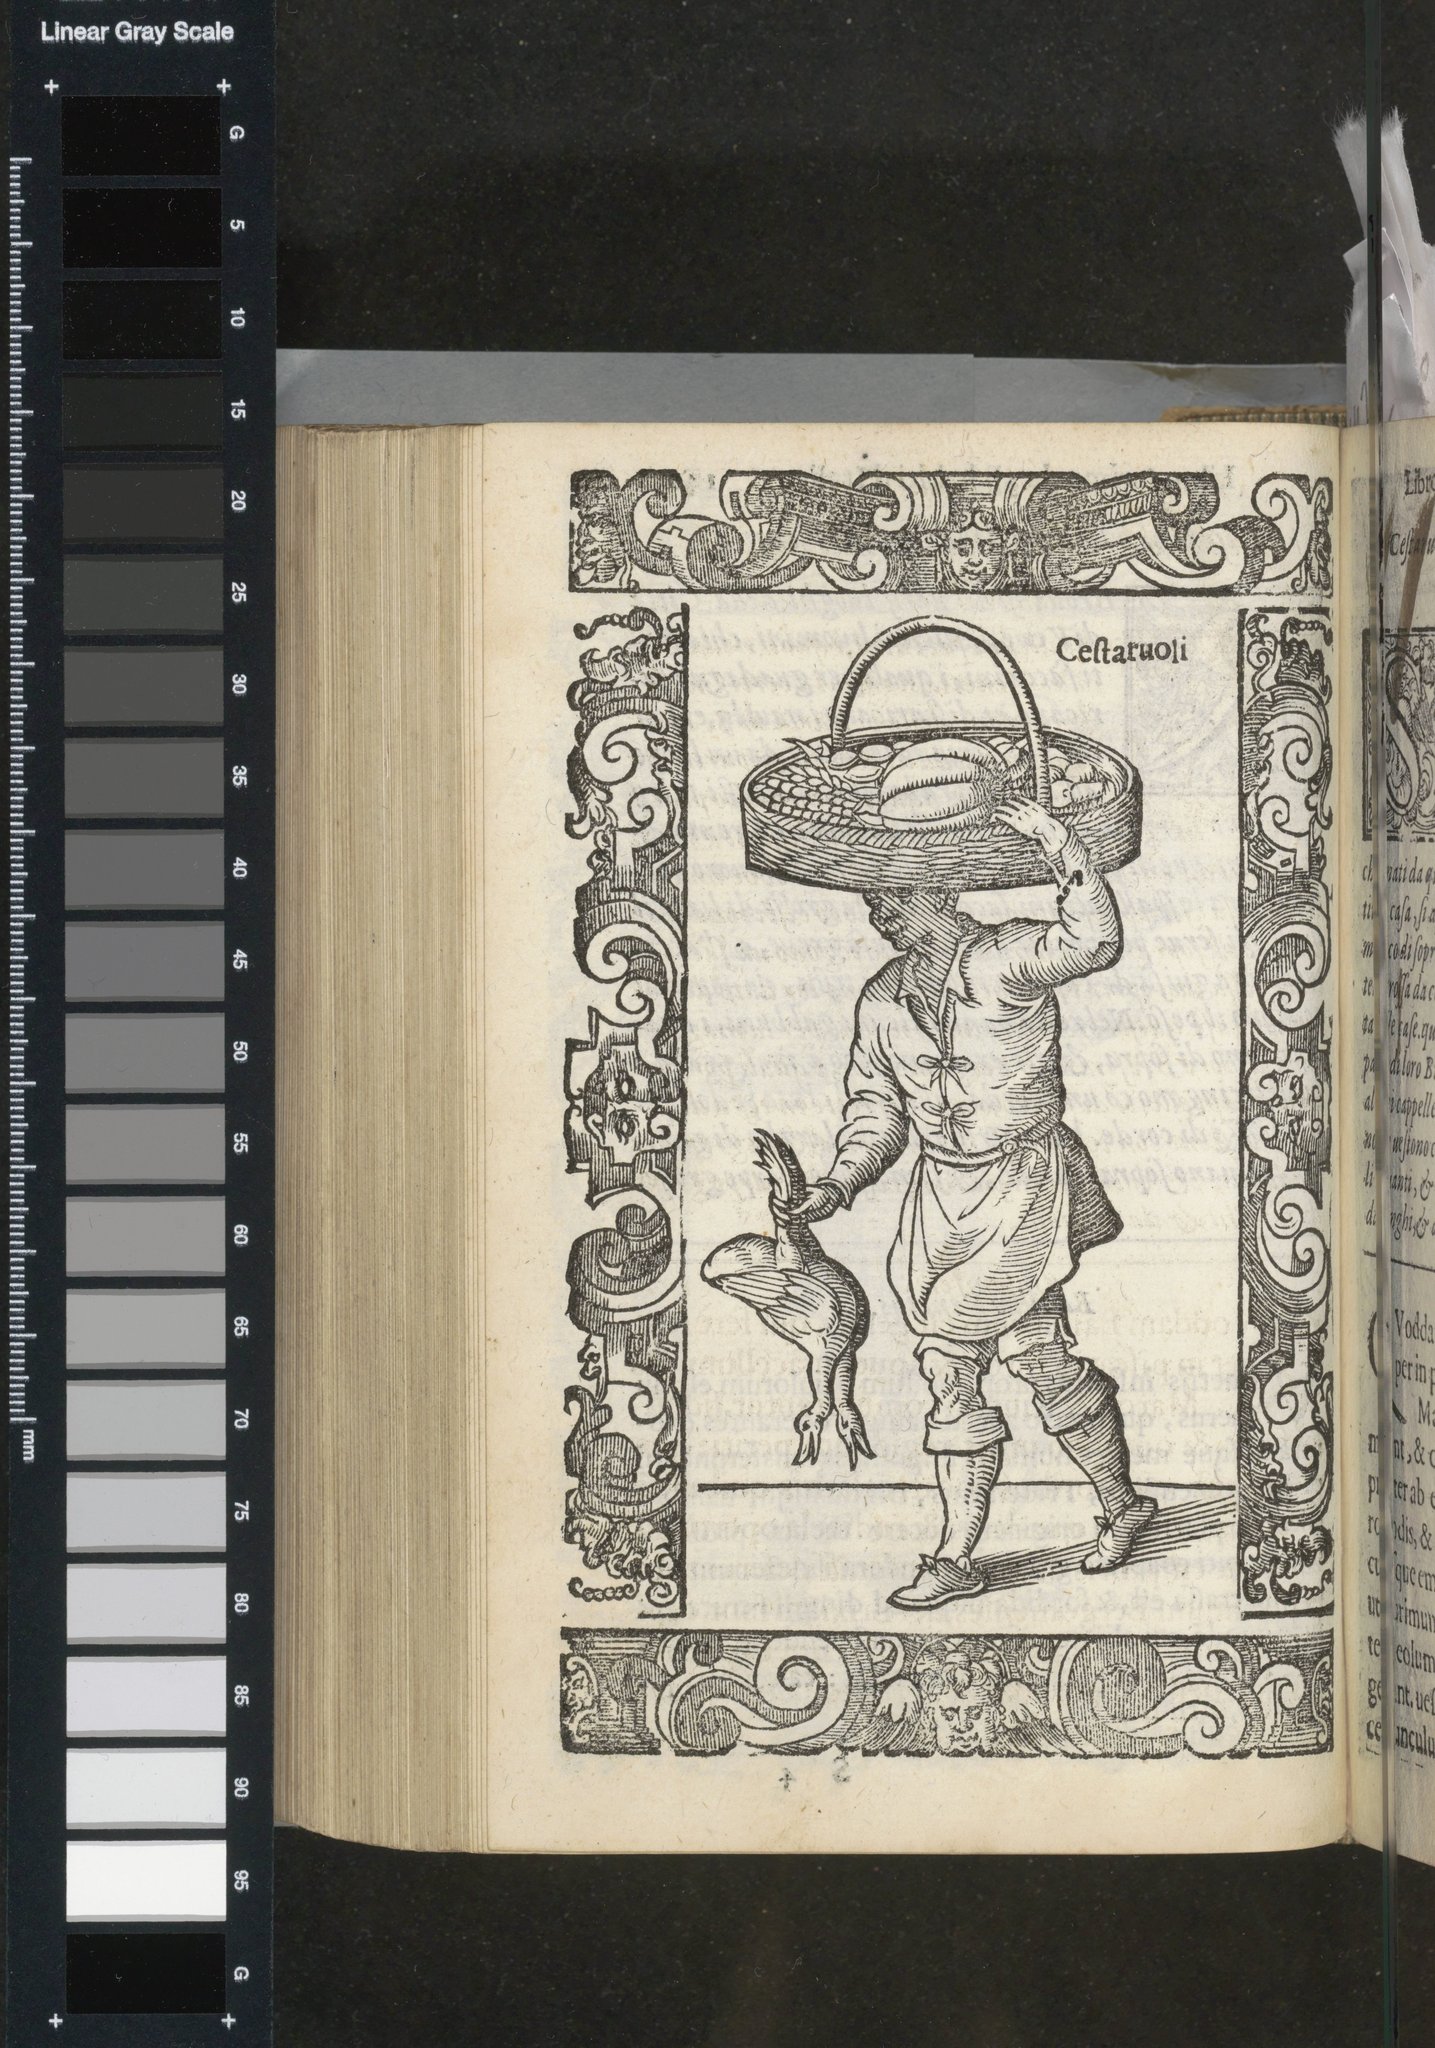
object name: costume print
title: Cestaruoli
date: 1598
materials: paper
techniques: woodcut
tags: fashion plates